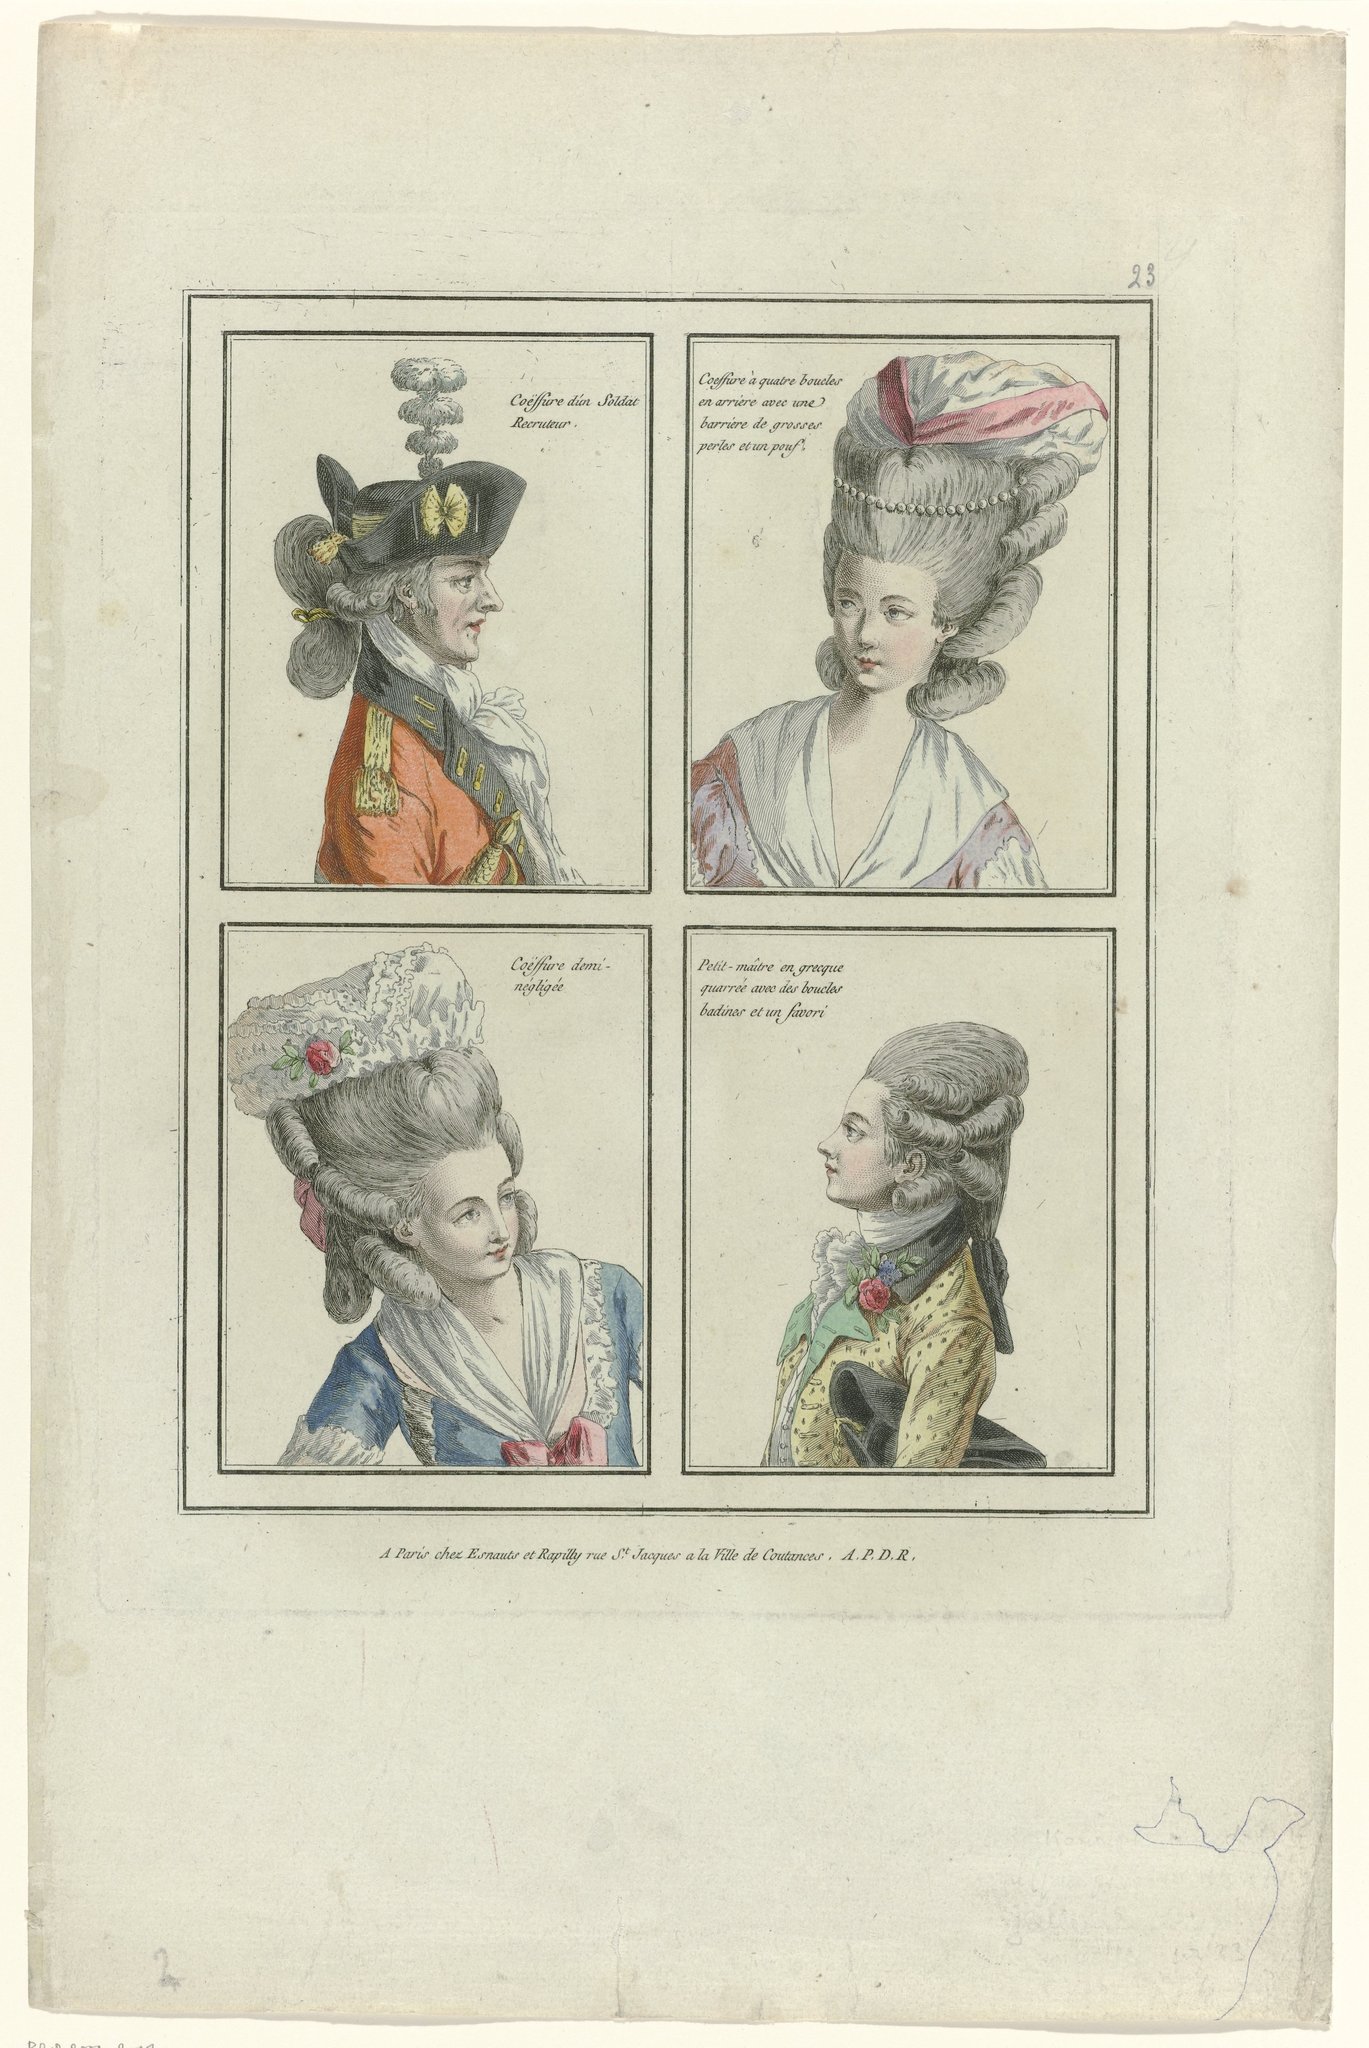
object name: fashion print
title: Gallerie des Modes et Costumes Français 1777-1778, D 23: Coëffure d'un Soldat recruteur (...)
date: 1777-1778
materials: paper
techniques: engraving, hand coloring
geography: paris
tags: dandy, beau, neck-gear ~ clothing (+ men's clothes), head-gear: hat (+ men's clothes), styles of hairdress, styles of hairdress - aa - ~ women, head-gear: cap (+ women's clothes), fashion plates, (military) uniforms, neck-gear ~ clothing (+ women's clothes)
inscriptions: inscription: ‘Coeffure d'un Soldat recruteur / Coeffure à quatre boucles en arriere avec une barriere de grosses perles et un pouf / Coeffure demi négligée / Petit-maître en grecque quarrée avec des boucles badines et un favori’, address: ‘A Paris chez Esnauts et rapilly rue St. Jacques a la Ville de Coutances. A.P.D.R.’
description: Twee mannen- en twee vrouwenkapsels met hoofdbedekking, verdeeld in vier kaders. Van linksboven naar rechtsonder: 'Coëffure d'un Soldat recruteur. Coeffure à quatre boucles en arriere avec une barriere de grosses perles et un pouf. Coëffure demi négligée. Petit-maître en grecque quarrée avec des boucles badines et un favori'. Prent uit serie D. 4e Cahier des Costumes Français pour les Coeffures en 1777 et 1778, Gallerie des Modes et Costumes Français.